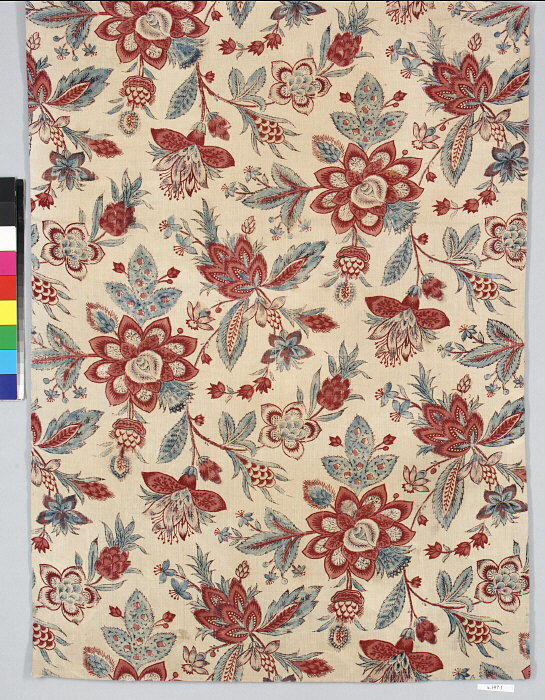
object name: piece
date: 1701-1800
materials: linen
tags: flowers,leaves